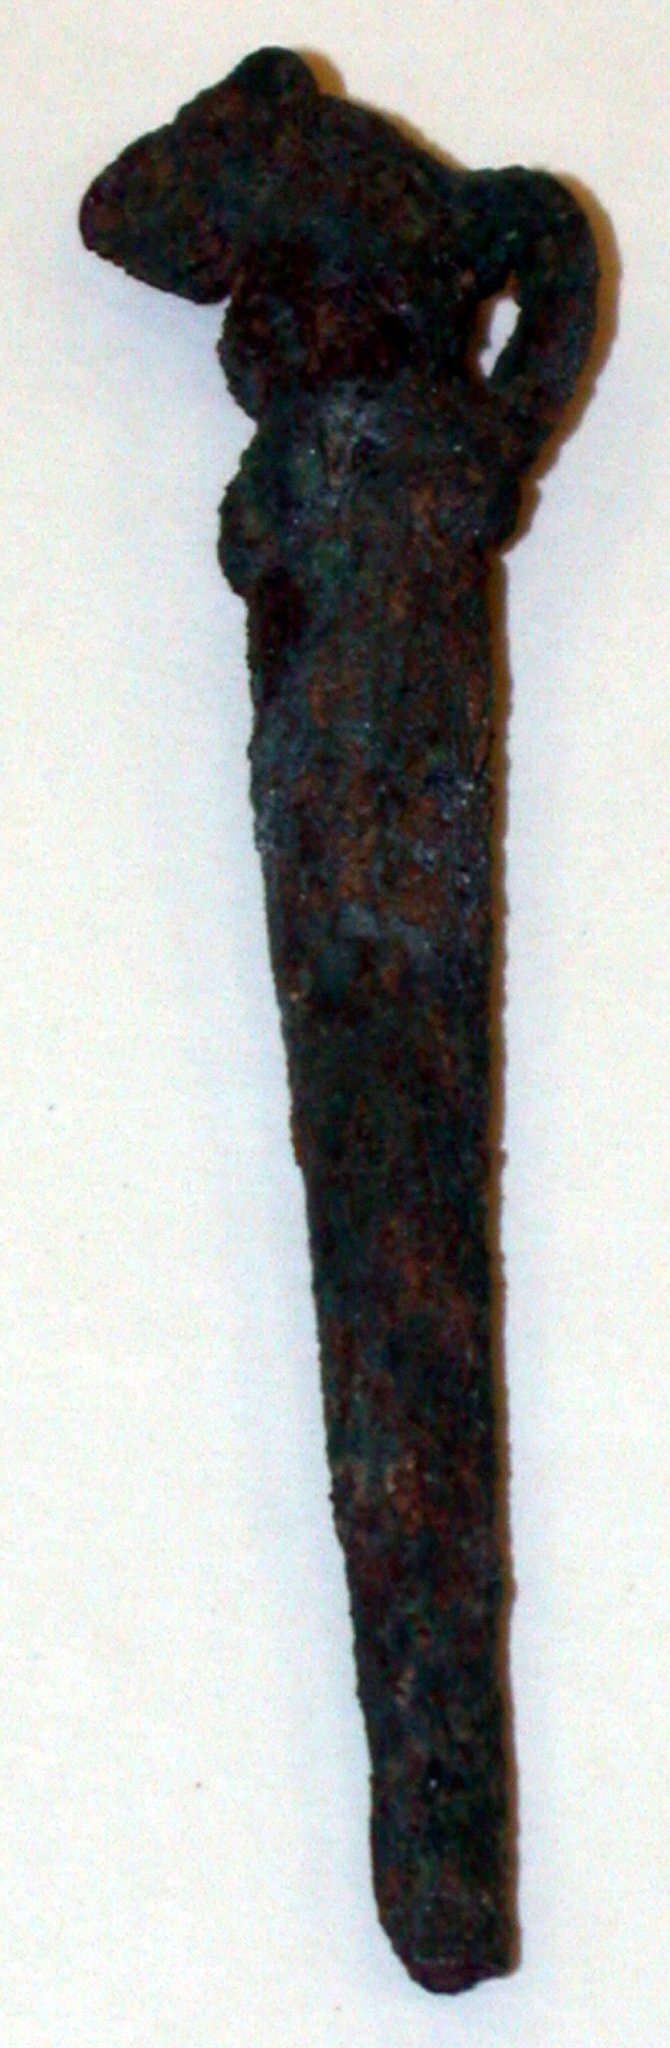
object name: pin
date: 3333-2668 BCE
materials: copper alloy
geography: iran